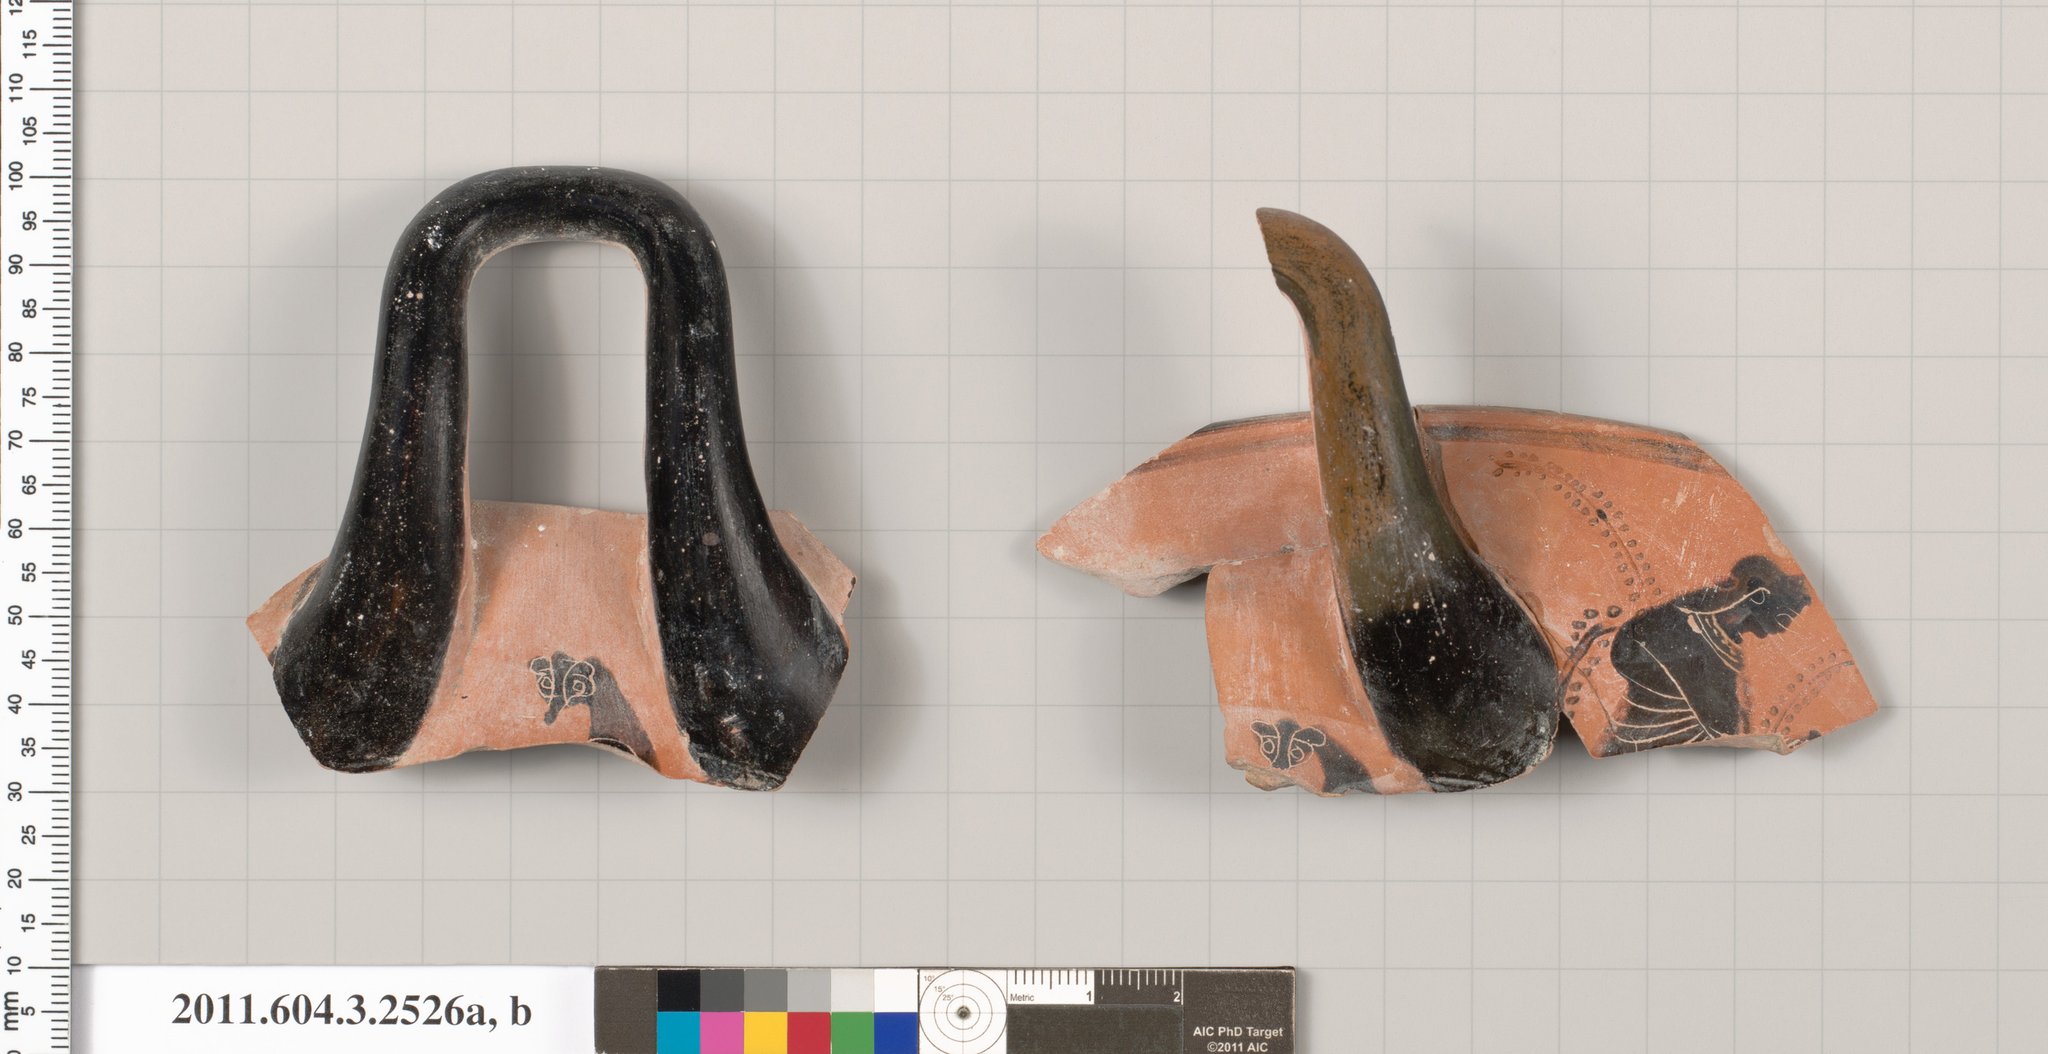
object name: kylix fragment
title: Terracotta fragments of a kylix (drinking cup)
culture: greek, attic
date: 534-468 BCE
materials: terracotta